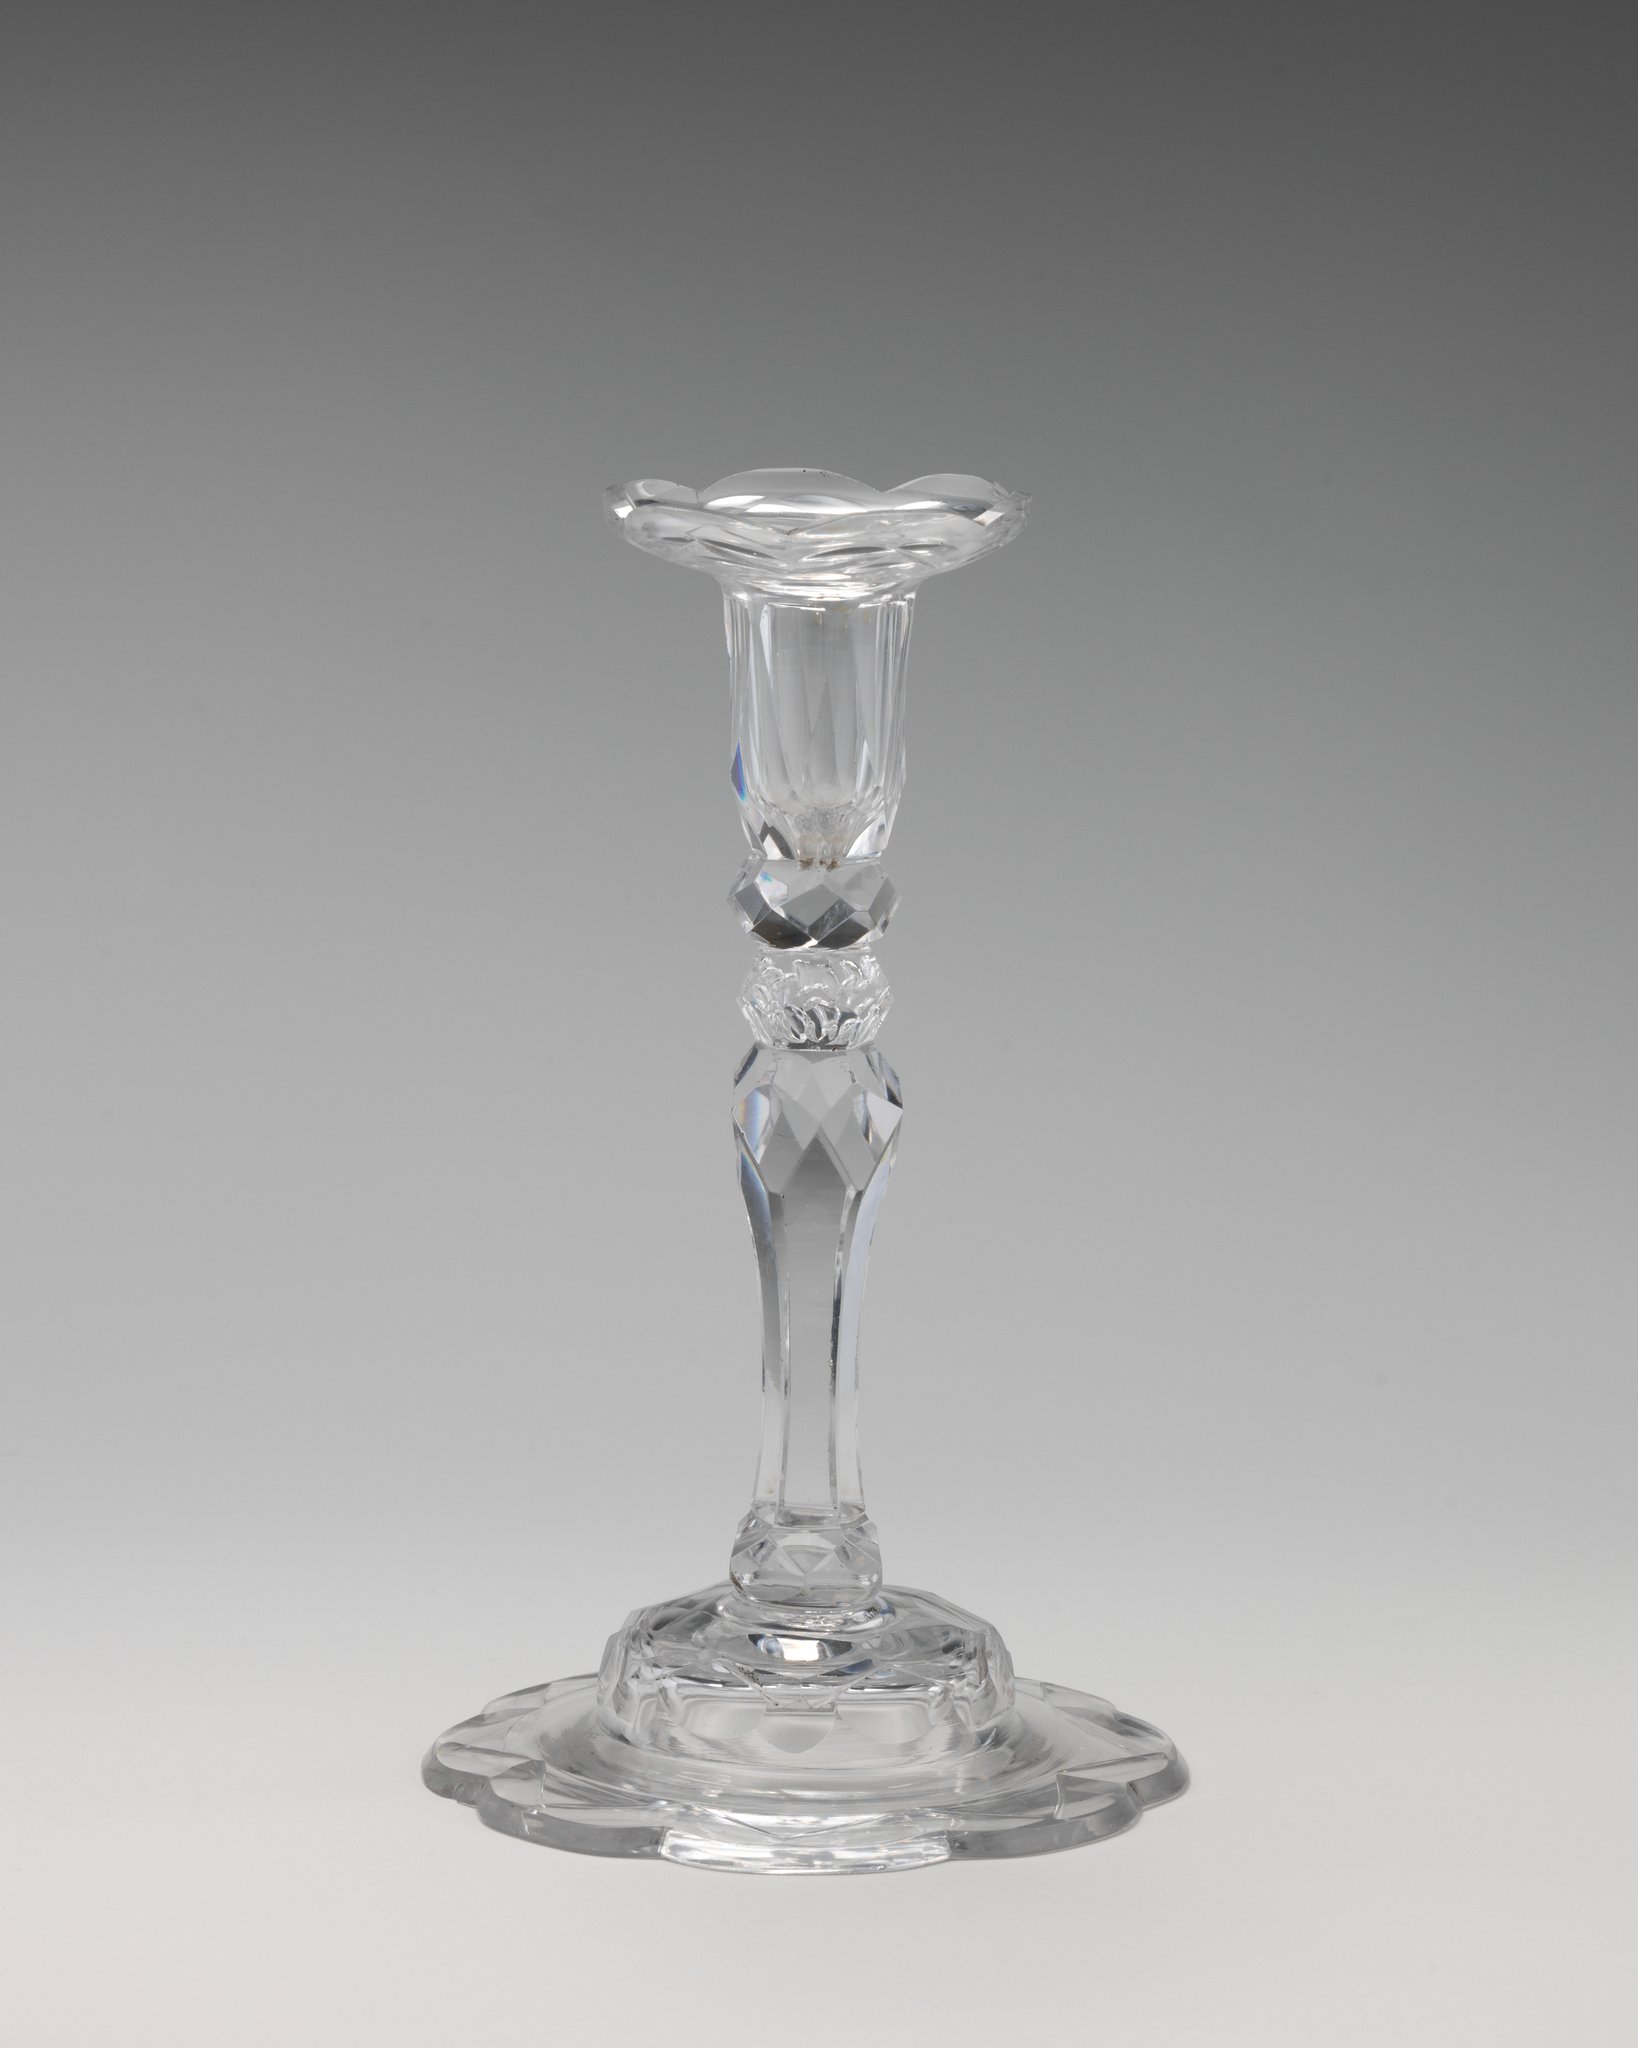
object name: taperstick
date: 1760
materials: glass